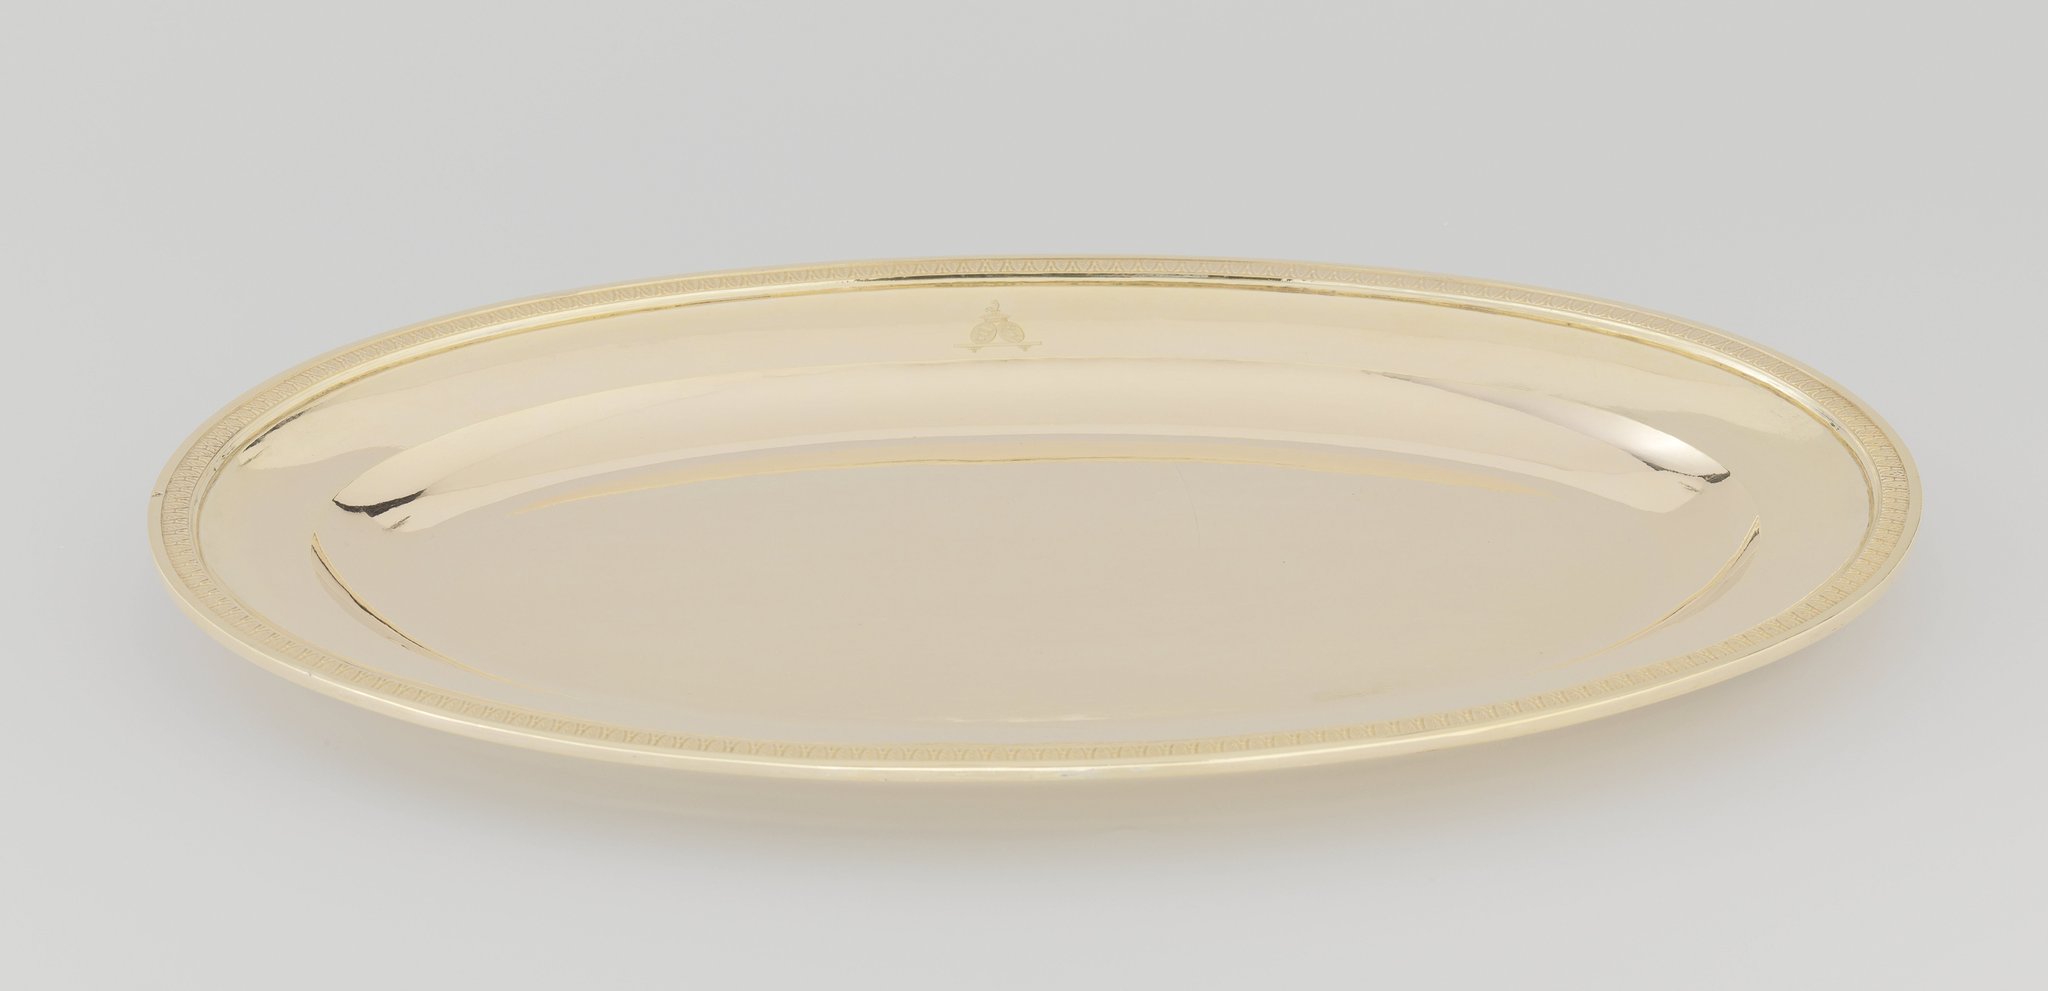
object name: platter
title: Oval dish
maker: jean baptiste claude odiot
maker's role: jeweler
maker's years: 1763-1850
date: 1819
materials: silver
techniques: gilding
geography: paris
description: These items are part of an 140-piece service that belonged to Alexandra Vasilievna Engelhardt, a noblewoman at the Russian court. The renowned silversmith Odiot collaborated with the painter Prud’hon and the architect Cavelier. They proudly presented their models at the French national crafts exhibition in 1819. The large late Empire figures, like the kneeling angels supporting the soup tureen, are striking.